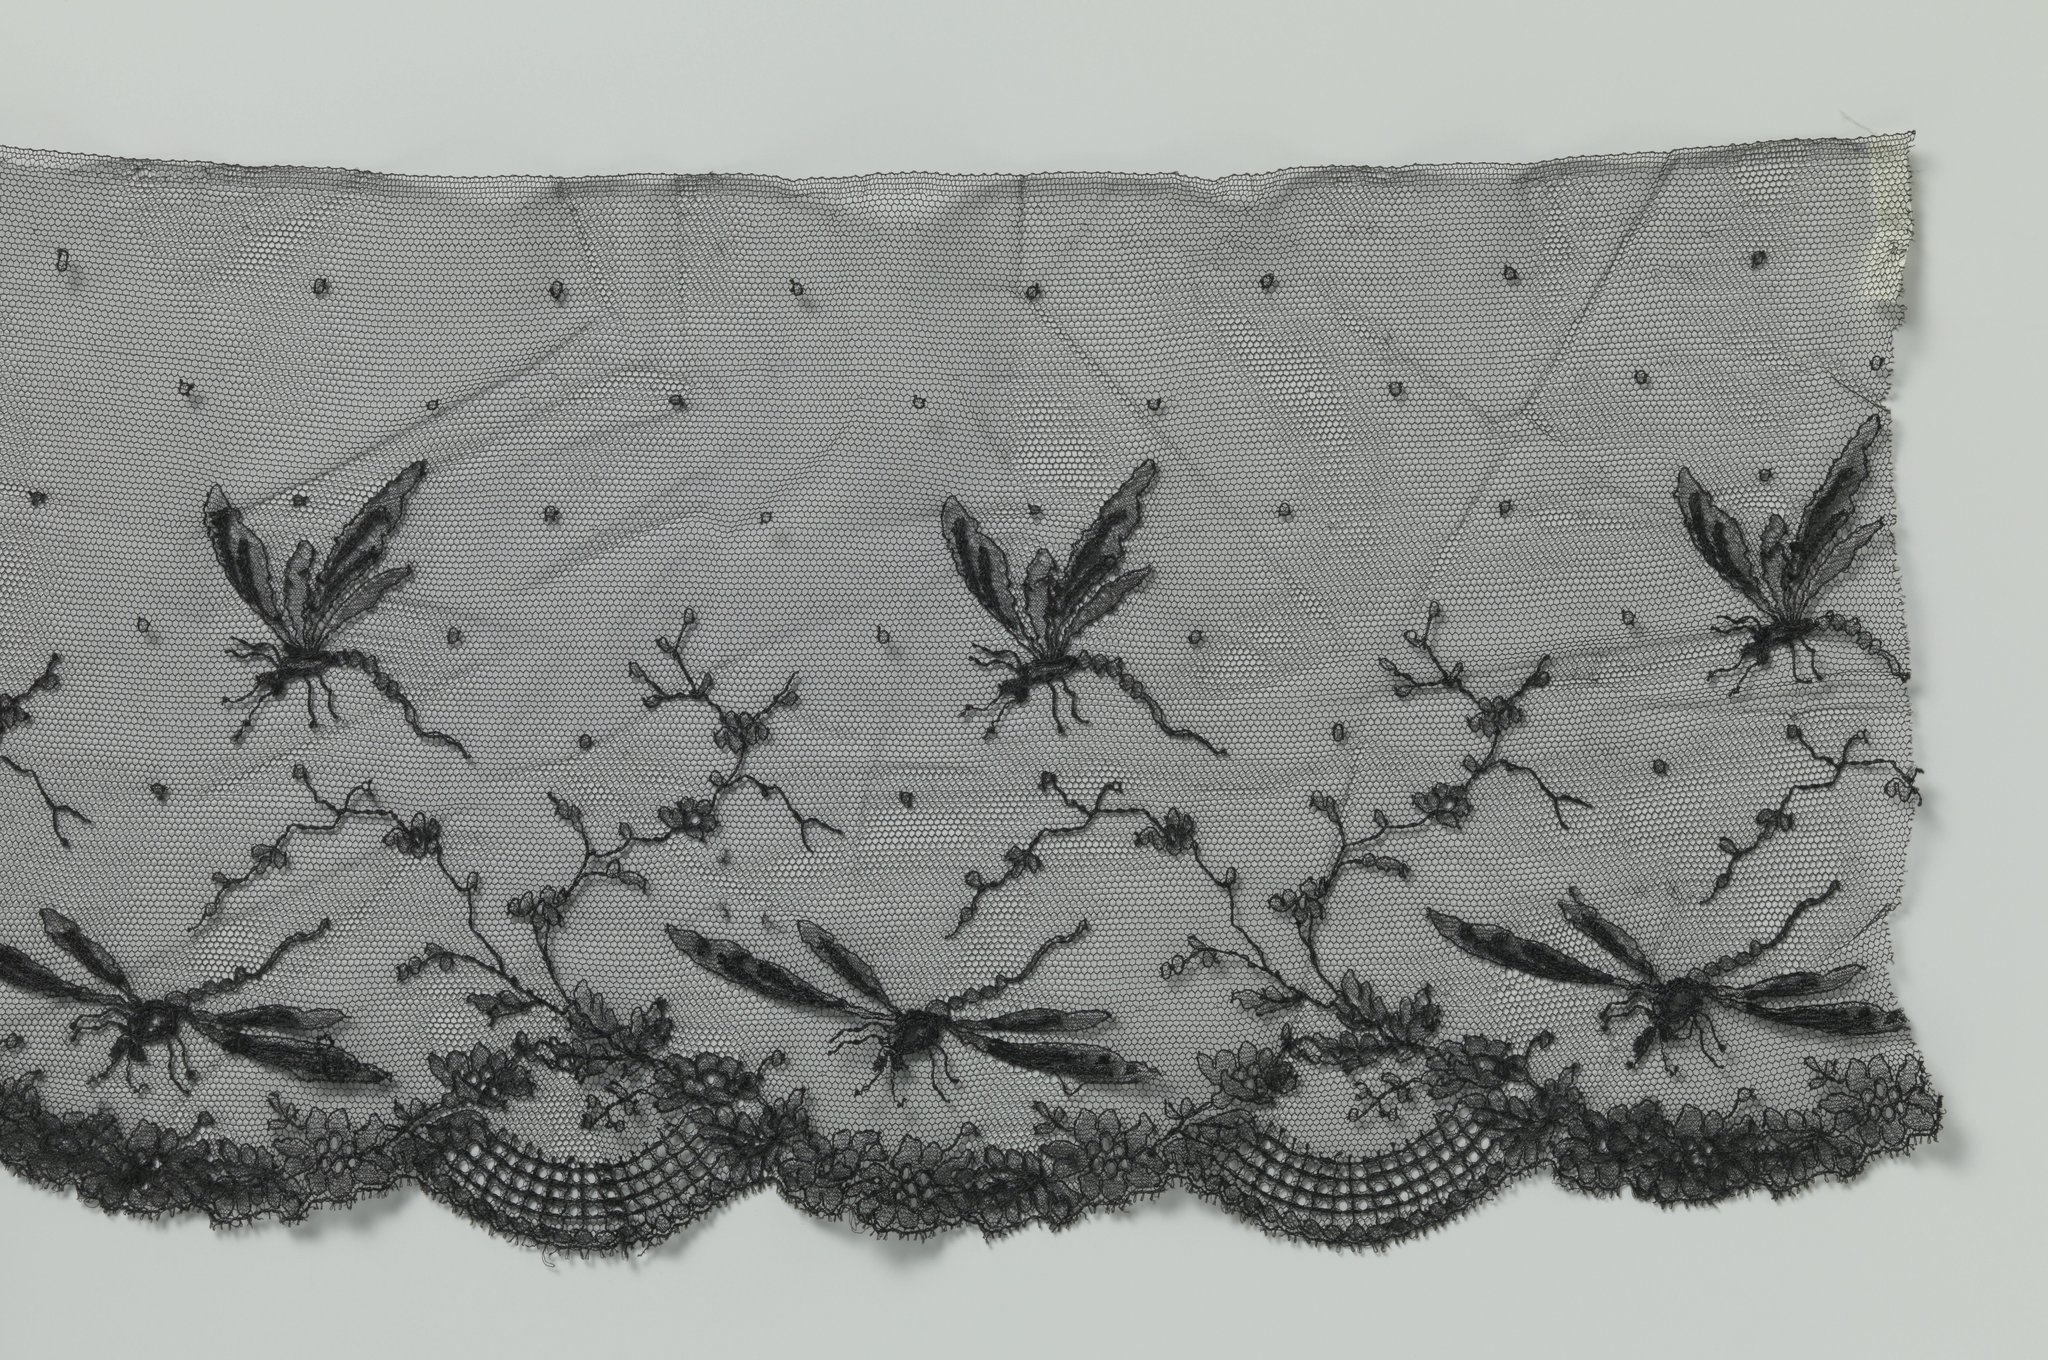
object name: strip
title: Strook zwarte machinale kant met libellen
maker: Anonymous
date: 1890-1899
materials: cotton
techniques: lace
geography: calais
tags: insects: dragon-fly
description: Strook zwarte machinale kant: machinale Chantilly-kant. Het zich herhalende patroon bestaat uit twee, bijna recht boven elkaar geplaatste, vliegende libellen. De vleugels van de bovenste libelle zijn meer omhoog gericht en die van de onderste libelle zijwaarts. Een ijle, gespleten rozentak met enkele bloempjes en blaadjes ontspringt onderaan de strook aan een golvende lijn, die bestaat uit een aaneenschakeling van rozentakjes. Onder elke golftop hangt een gebogen korte sierband met een vierkant raster. De motieven zijn voorzien van contourdraden en zijn met elkaar verbonden door een machinale tulegrond, die is bezaaid met moesjes. Als siergrond is onder andere een machinale rozengrond toegepast in de gebogen sierband en in de bloemharten. De gebogen sierband vormt onder de toppen van de doorgaande golvende rozentakjes de schulpenrand, die is afgewerkt met picots. De bovenzijde van de strook is recht afgewerkt.